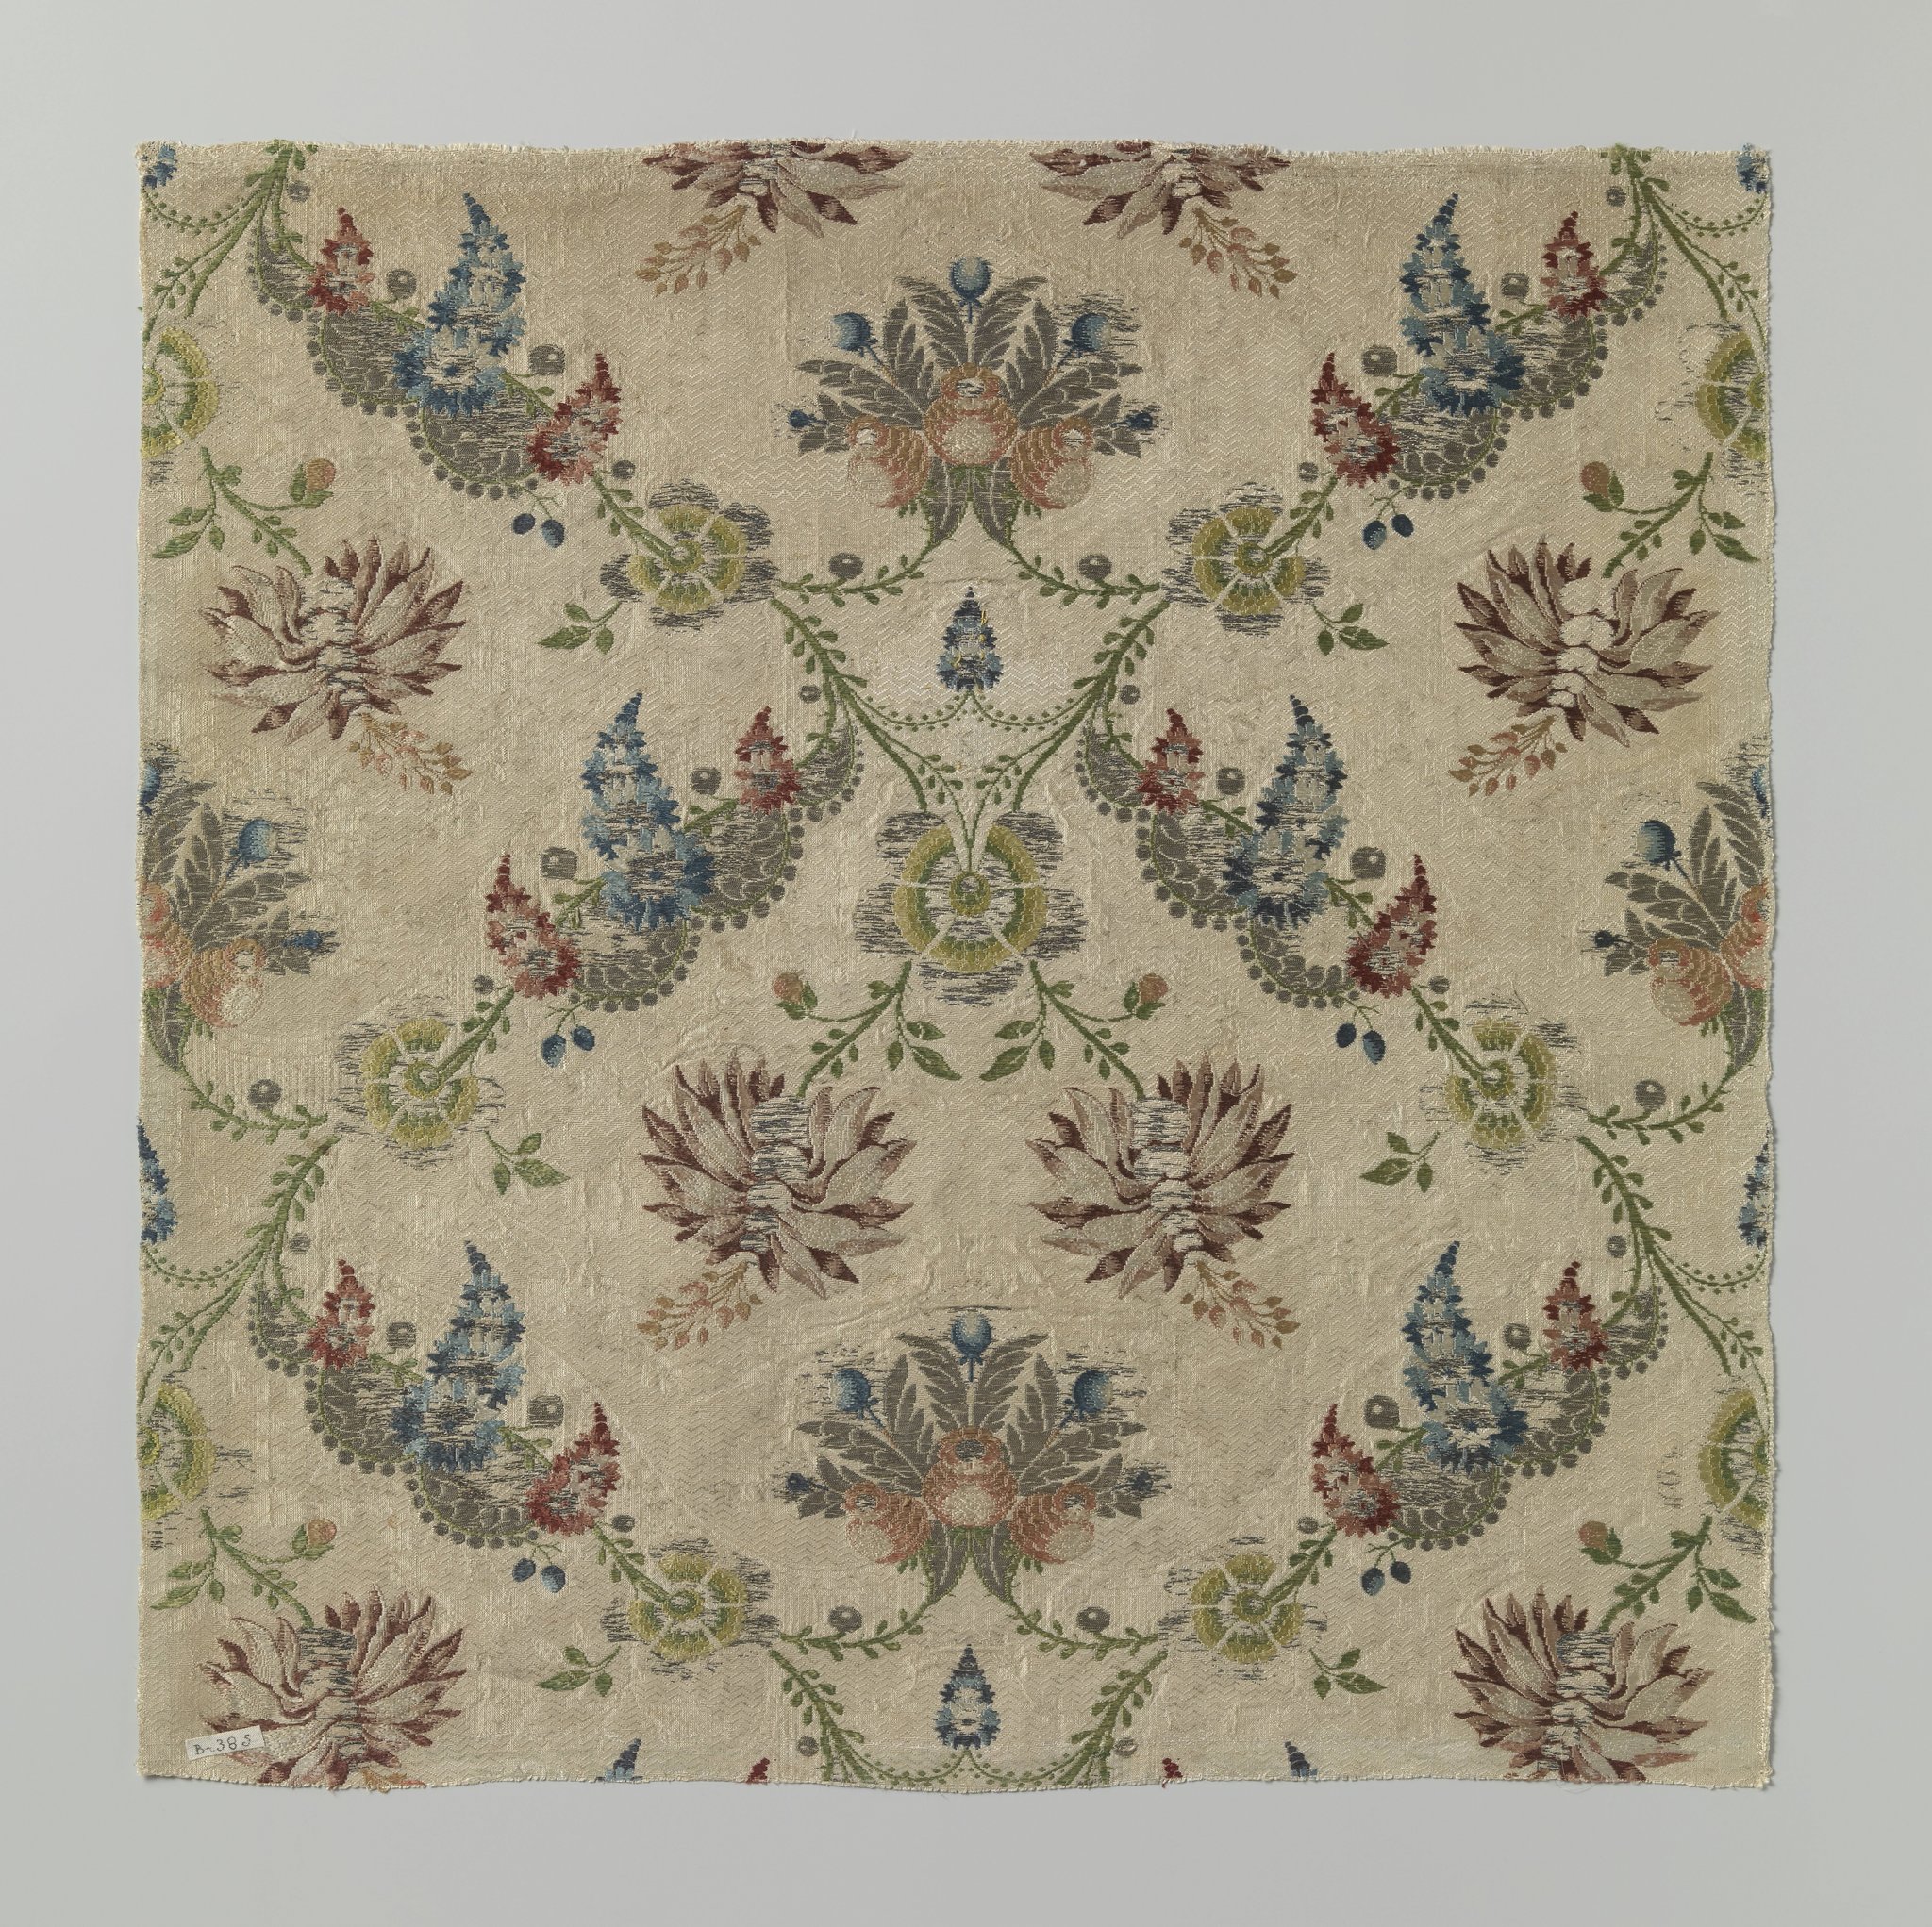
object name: fragment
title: Fragment van een veelkleurige gebrocheerde zijde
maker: Anonymous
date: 1735-1760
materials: metal thread, silk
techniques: brocade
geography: france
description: Een zijdeweefsel met een roomkleurige grond en een symmetrische tekening. Op de roomkleurige grond met zigzagreliëfs een symmetrische tekening, uit een gele rozet ontwikkelen zich stengels met rood genuanceerde bloemen en diagonaalsgewijze geplaatste takken met zilveren bladeren en trossen rode en blauwe bloemen, die zich zowel boven als onder verenigen in een palmet-motief.